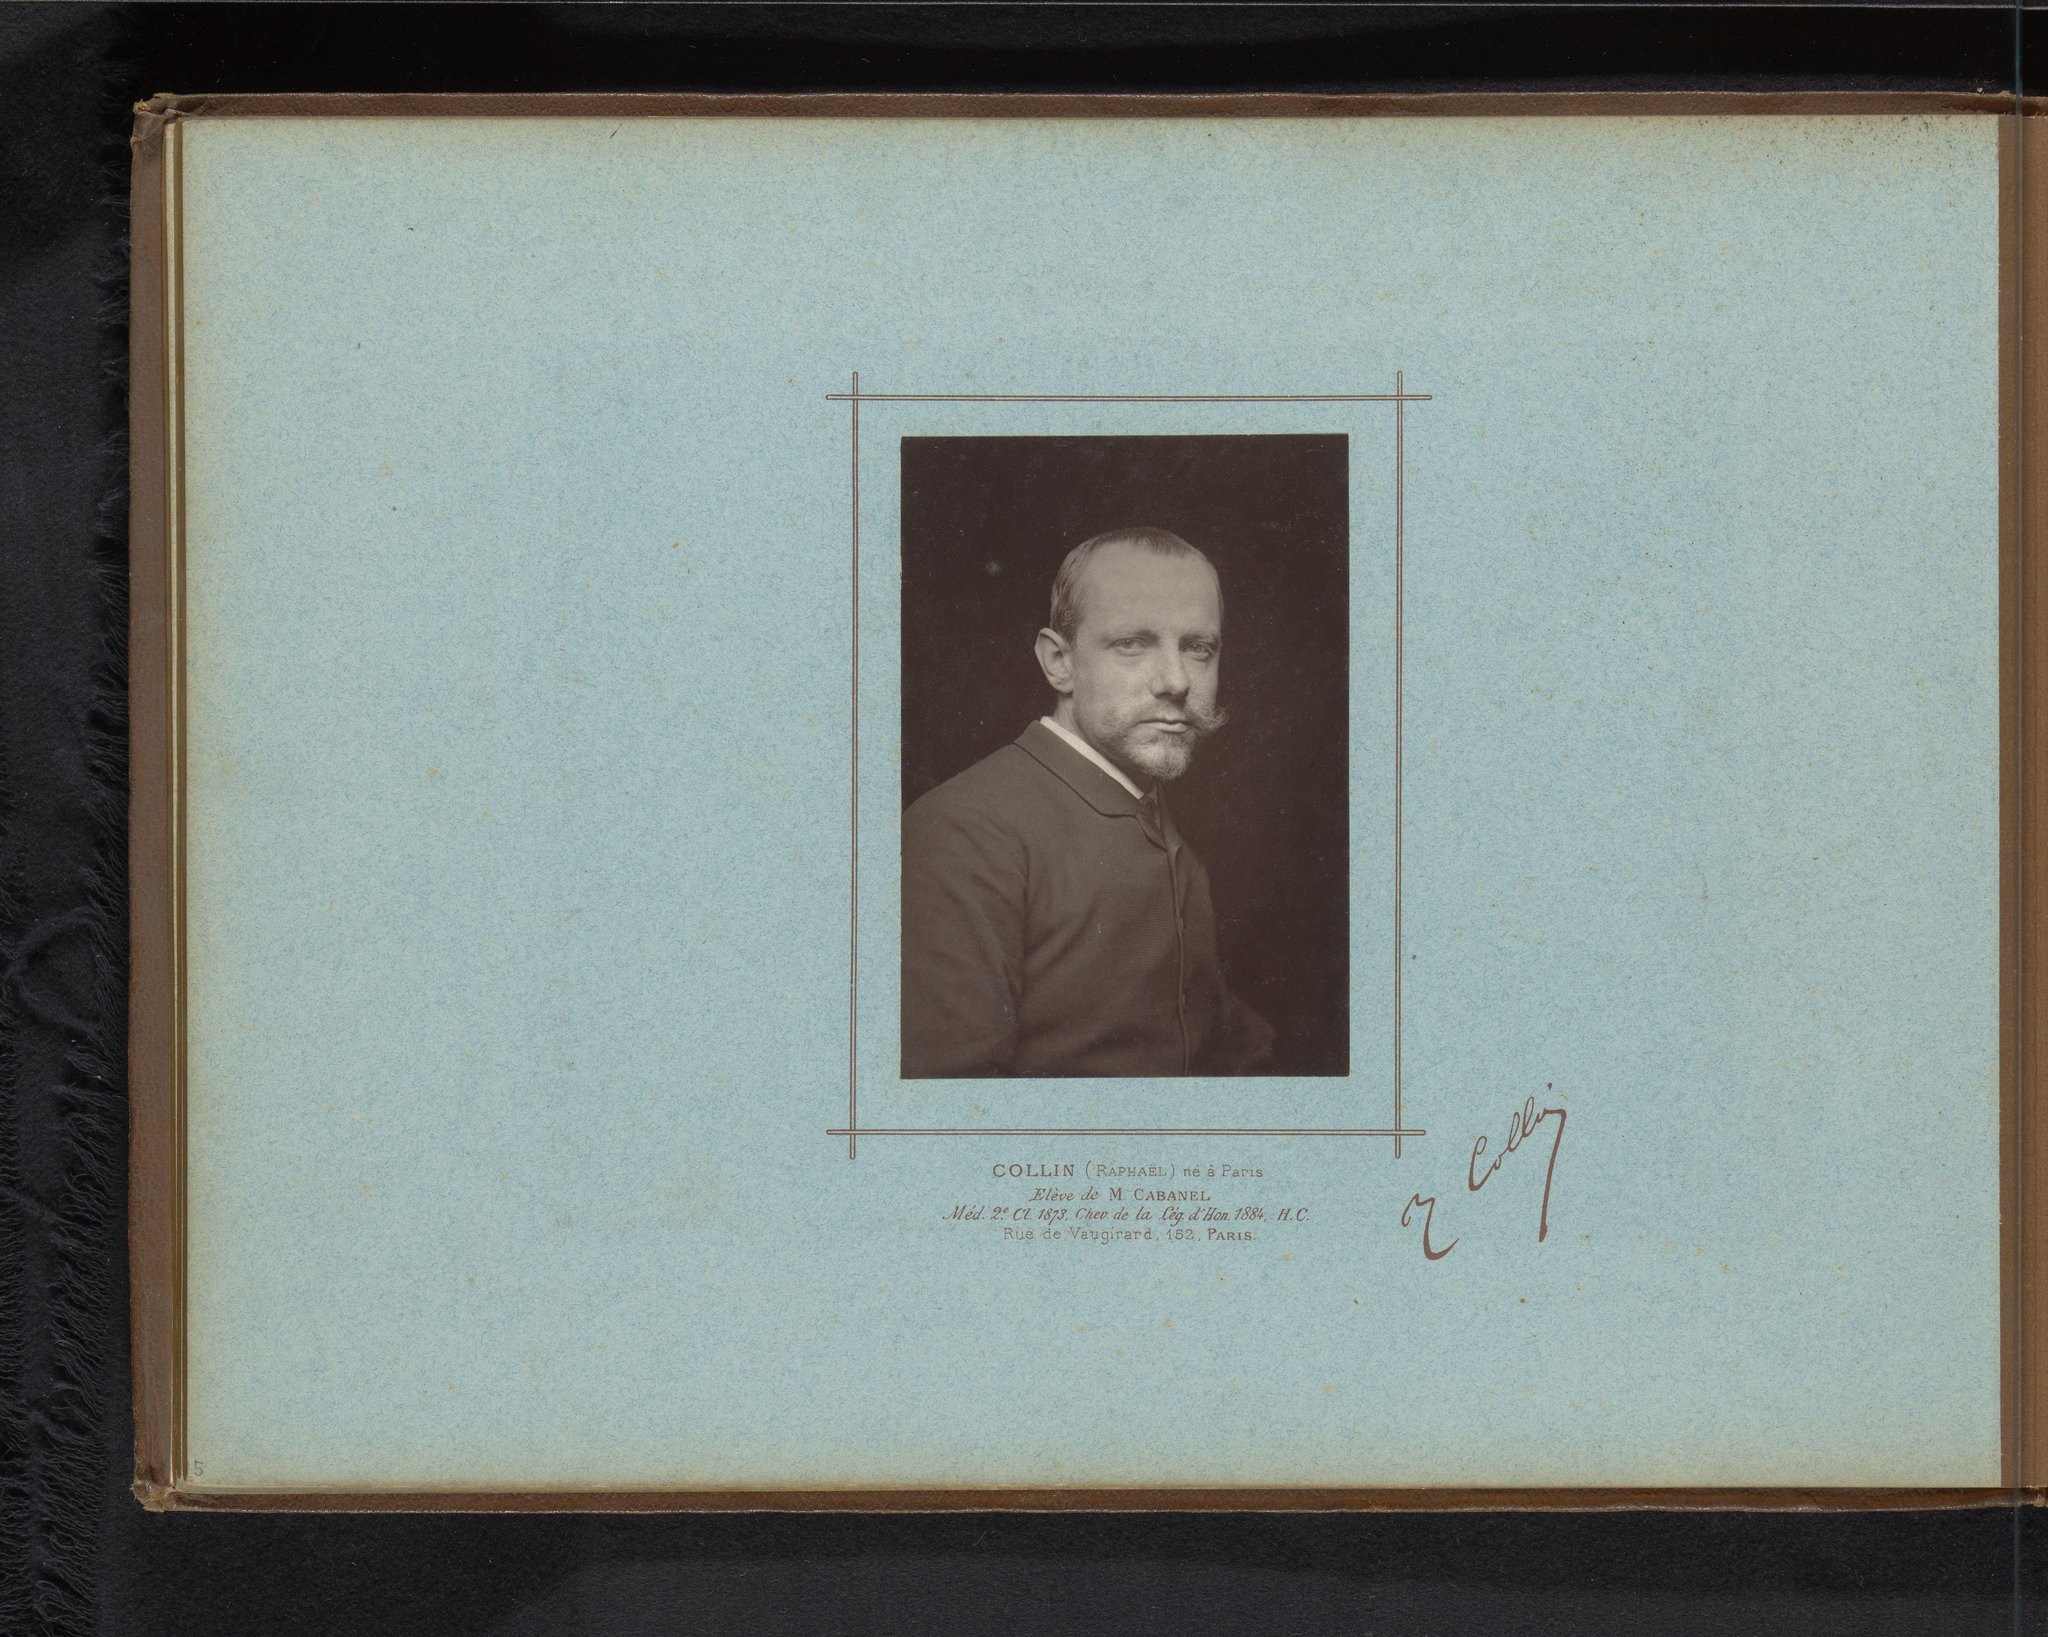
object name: photomechanical print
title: Portret van Raphaël Collin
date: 1879-1884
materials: paper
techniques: woodburytype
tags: paris, painter, raphaël collin, historical persons, portrait, self-portrait of painter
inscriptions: signature: ‘R Collin’, inscription: ‘COLLIN (Raphaël) né à Paris/ Élève de M. Cabanal/ Méd. 2e. Cl. 1873. Chev. de la Lég. d'Hon. 1884, H.C./ Rue de Vaugirard, 152, Paris.’